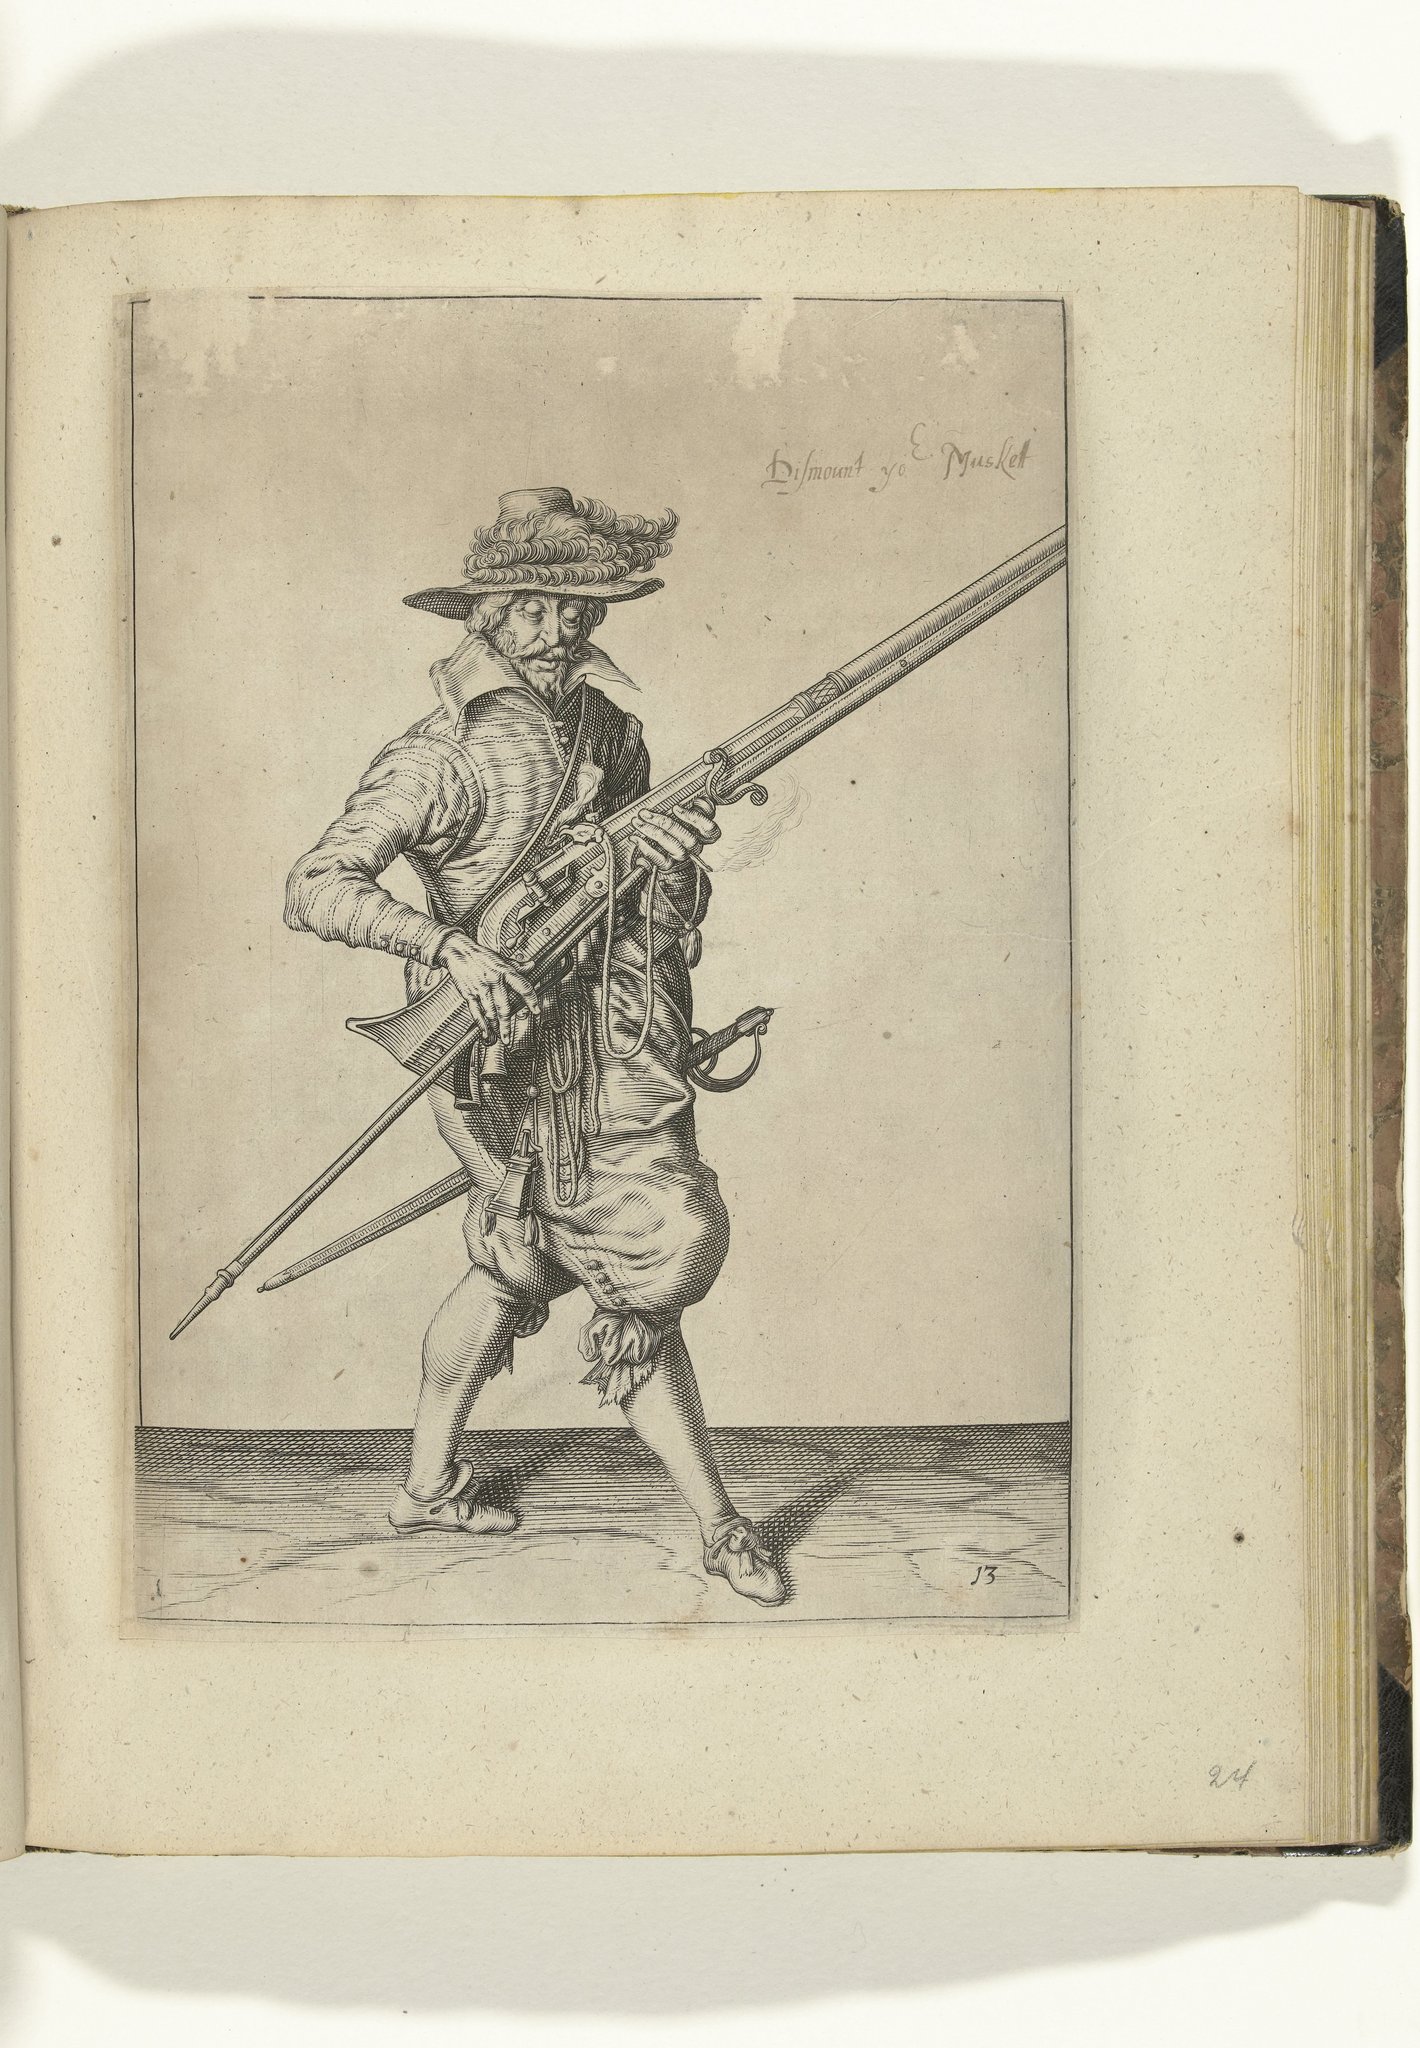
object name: print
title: Soldaat die zijn musket met zijn linkerhand schuin omhoog gericht vasthoudt, terwijl hij zijn furket onder de loop vandaan trekt (nr. 13), ca. 1600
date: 1597-1608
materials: paper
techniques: engraving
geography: northern netherlands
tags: maurice (prince of orange), handling of weapons ~ military training, weapons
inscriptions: inscription: ‘Dismount ye Muskett’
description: Een soldaat, ten voeten uit, naar rechts, die een musket (een bepaald type vuurwapen) met zijn linkerhand vasthoudt, nadat hij gevuurd heeft, de loop schuin omhoog gericht om te voorkomen dat hij ongewild een gezel verwondt (nr. 13), ca. 1600. In zijn linkerhand behalve het roer ook een brandende lont. Met zijn rechterhand trekt hij het furket (de musketvork) onder de loop vandaan. Plaat 13 in de instructies voor het hanteren van het musket: Shorte instruction for the figures, so much concerneth the right use of muskett. Onderdeel van de illustraties in een Engelse editie van J. de Gheyns Wapenhandelinghe: J. de Gheyn, The exercise of armes for calivres, muskettes and pikes after the ordre of Maurits Prince of Orange, 's-Gravenhage 1608. Krijgswezen rond 1600.